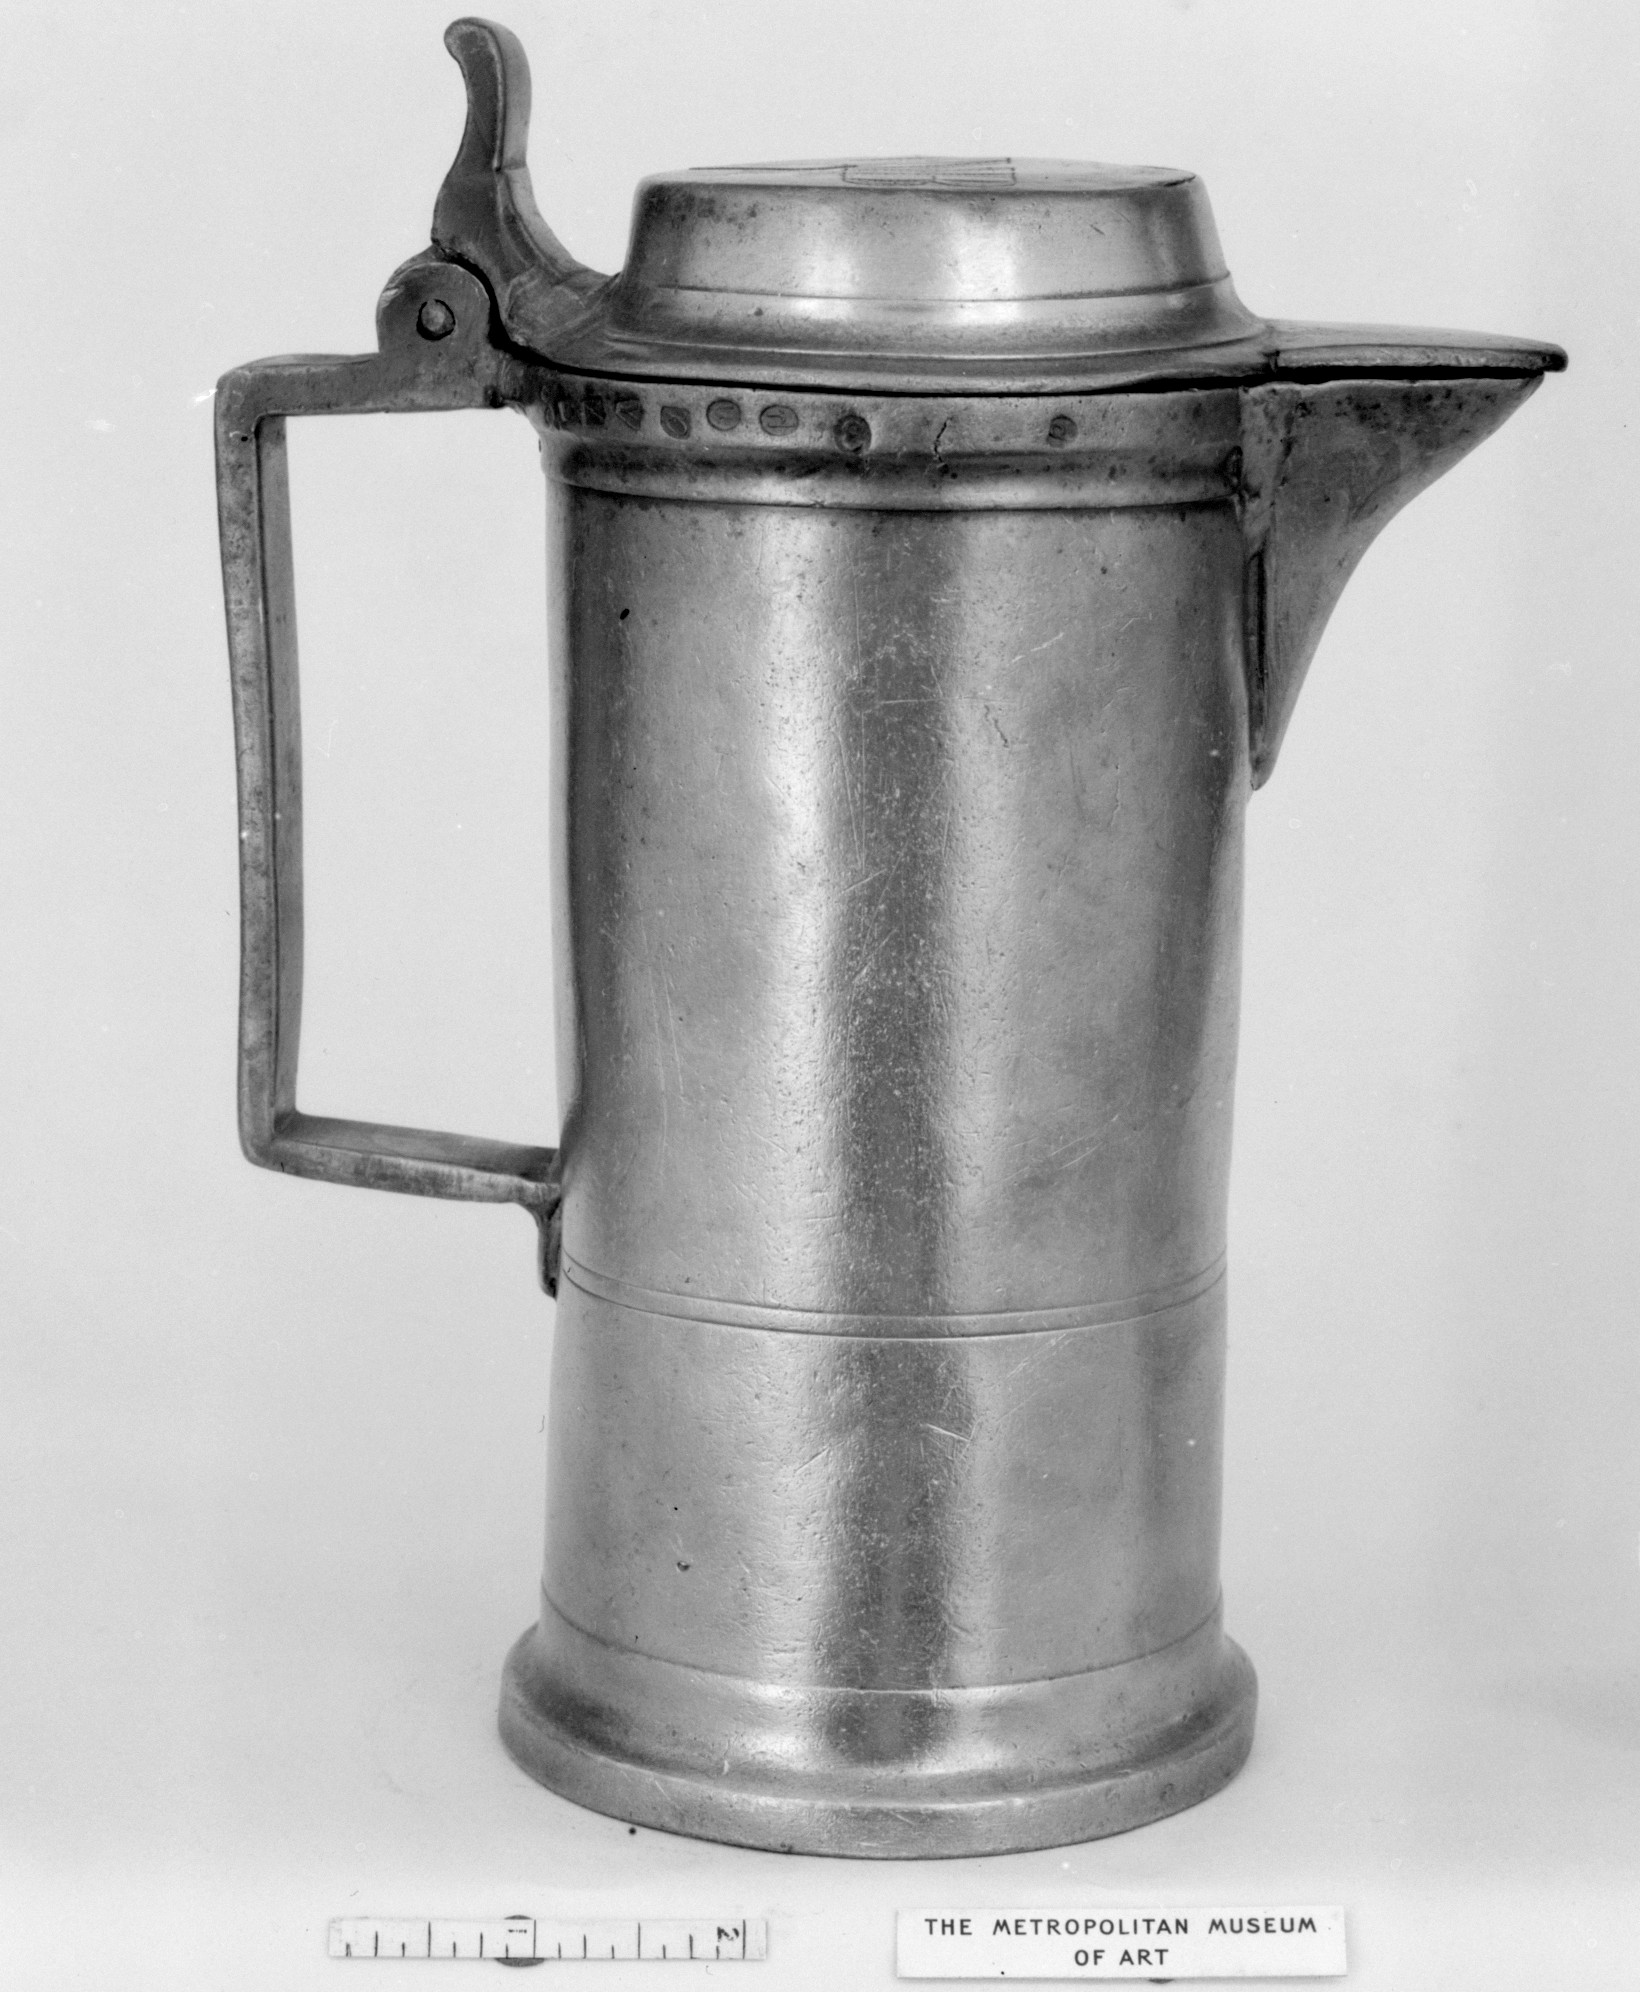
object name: measure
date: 1701-1800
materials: pewter